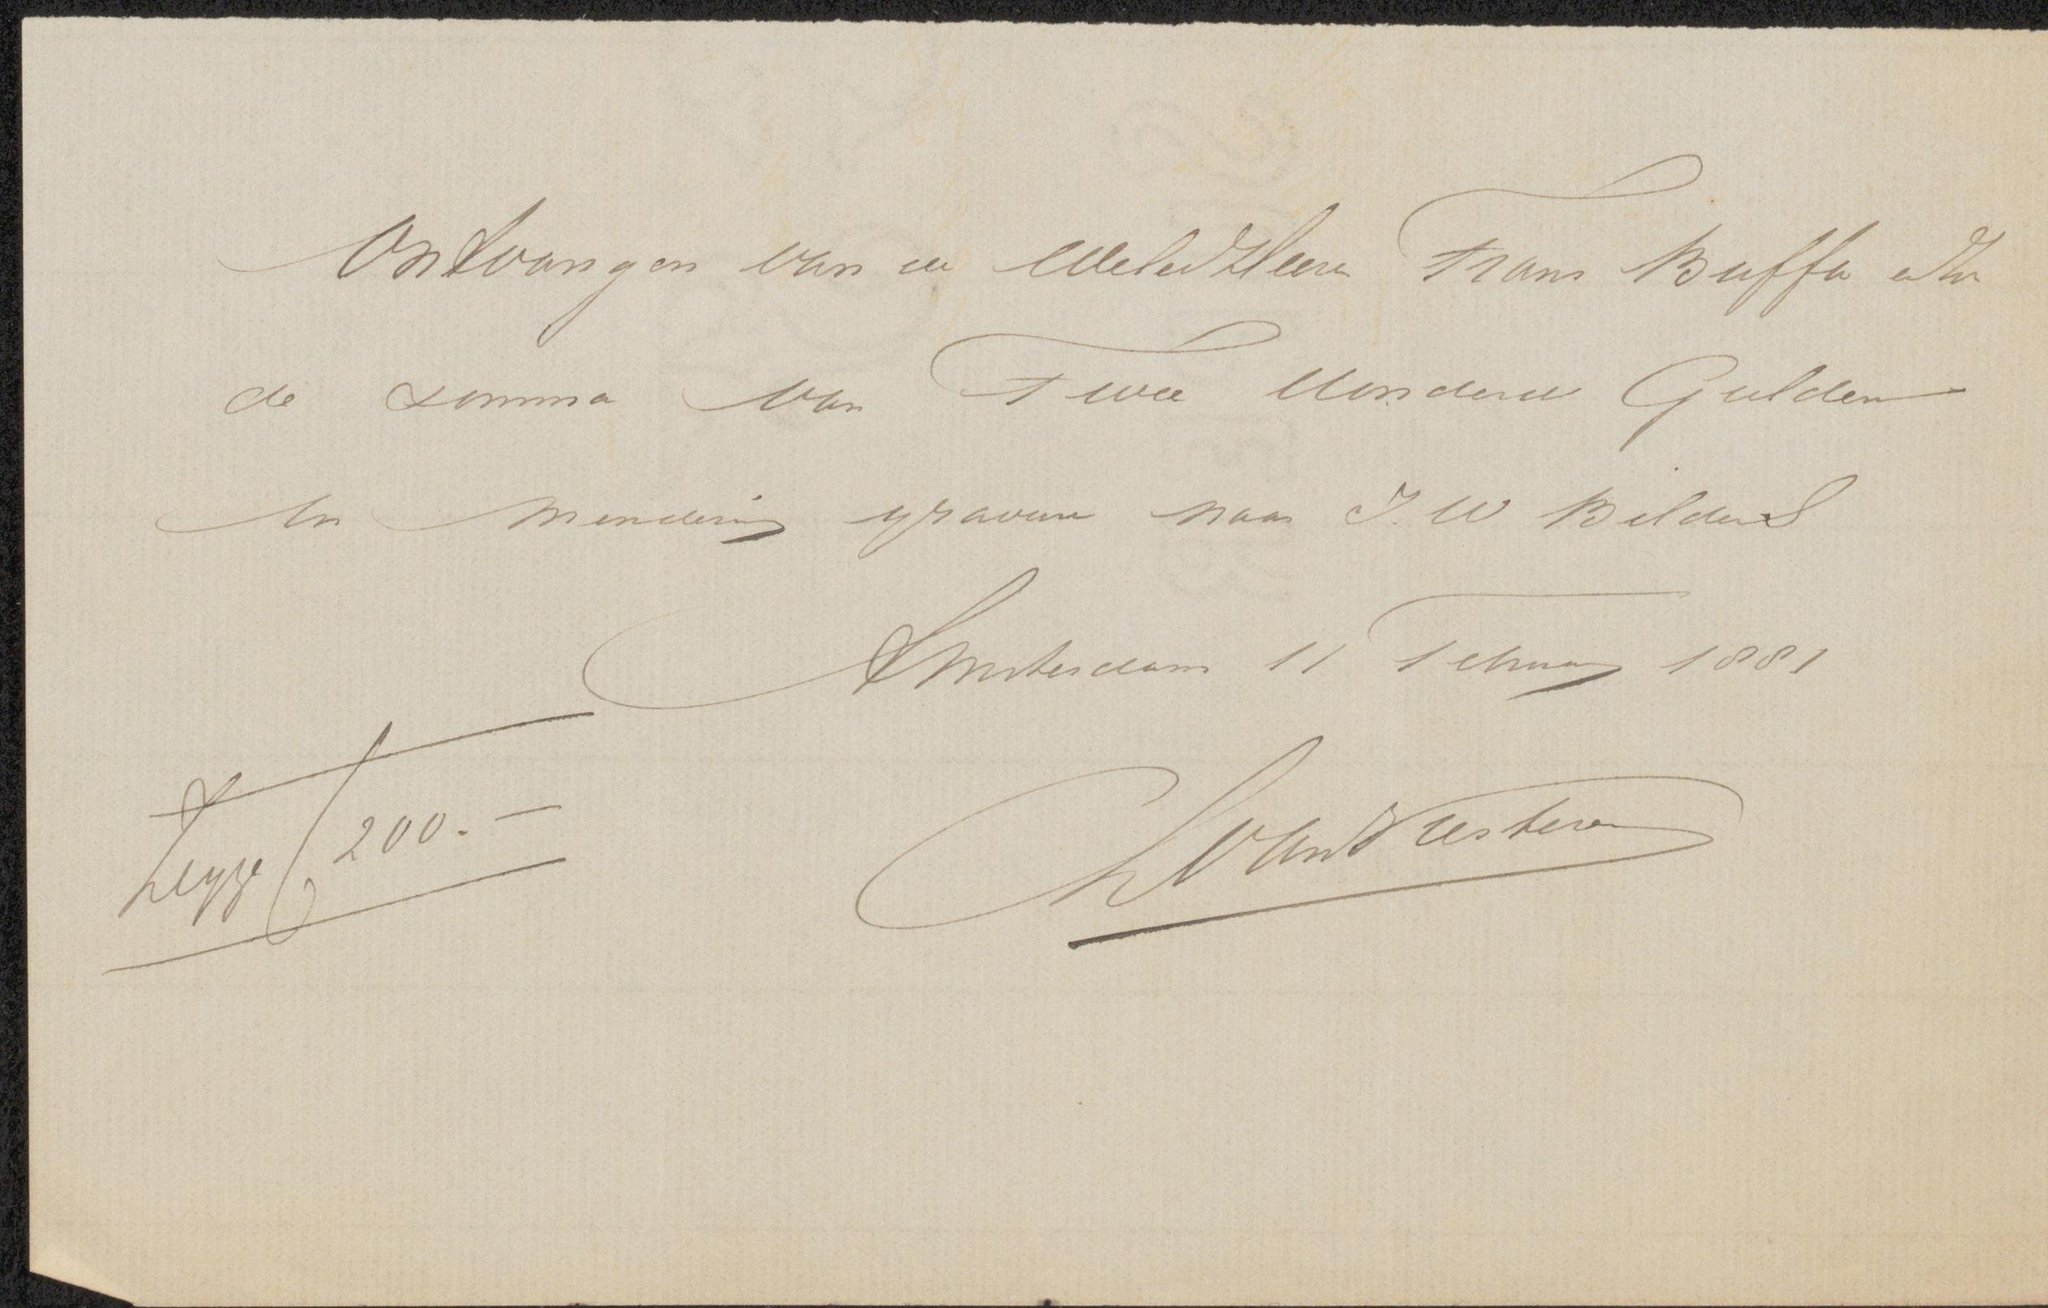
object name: ontvangstbewijs, kwitantie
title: Kwitantie voor Frans Buffa en Zonen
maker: christiaan lodewijk van kesteren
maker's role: print maker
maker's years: 1832-1897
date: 1881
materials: ink, paper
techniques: pen, writing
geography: amsterdam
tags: painter, johannes warnardus bilders, publisher, the graphic arts, money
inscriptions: watermark, collector's mark: Lugt 2233